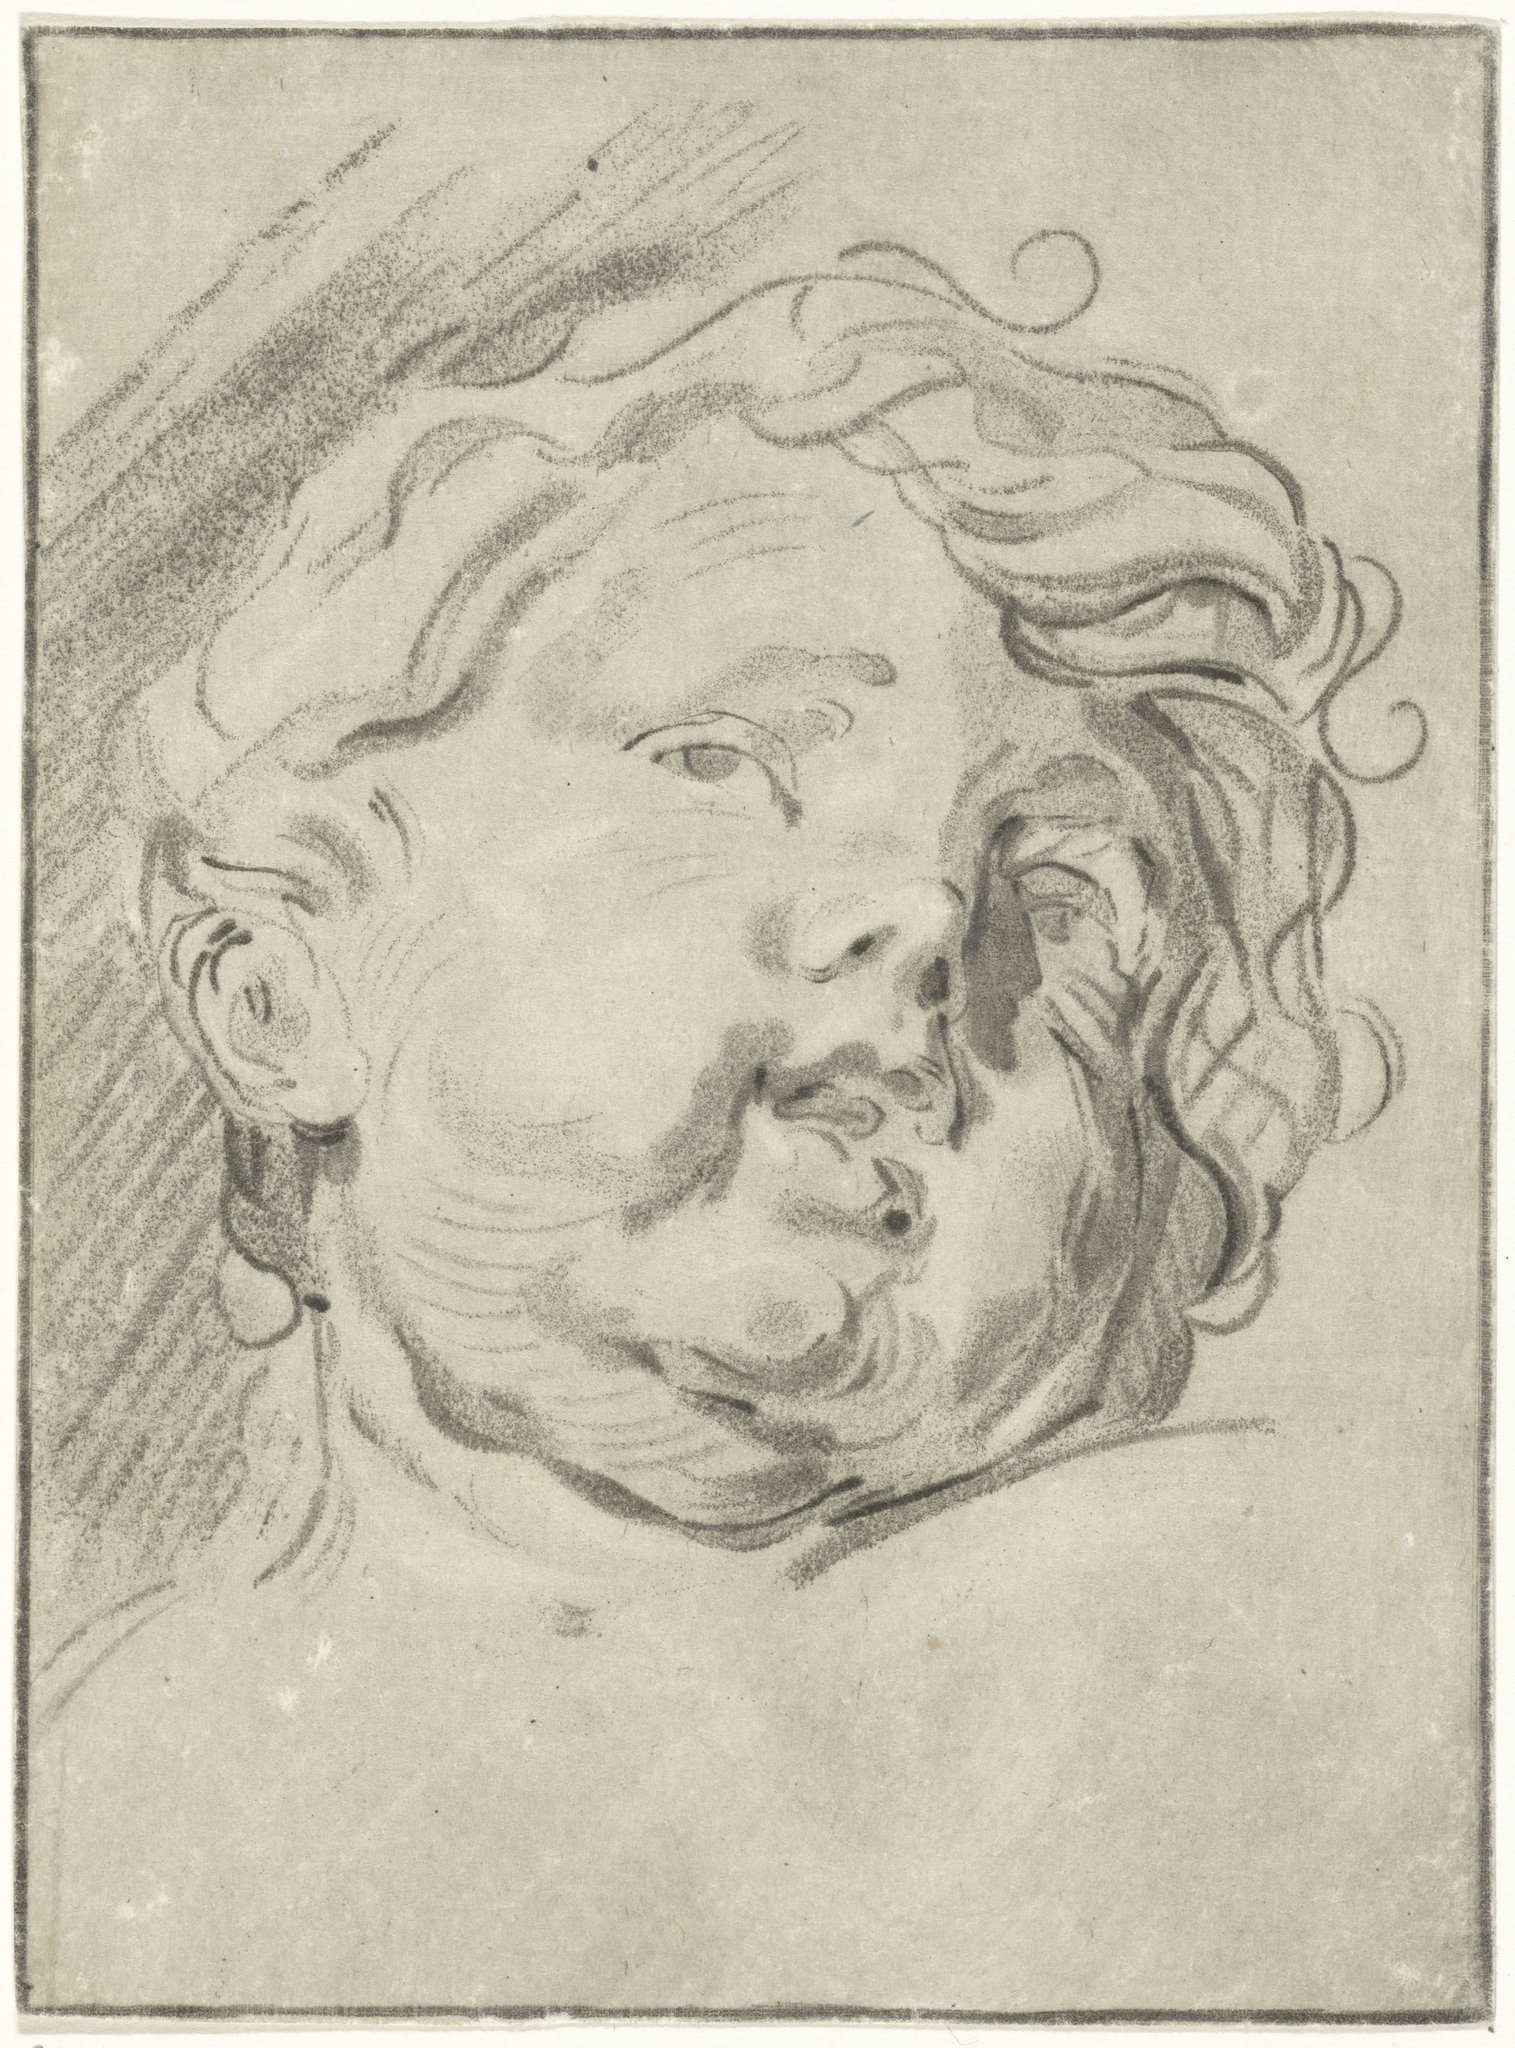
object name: print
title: Gezicht van een engel of putto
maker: bernhard schreuder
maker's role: print maker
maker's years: -1780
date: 1767-1780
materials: paper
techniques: printmaking, etching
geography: netherlands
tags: angels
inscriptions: collector's mark: Lugt 240